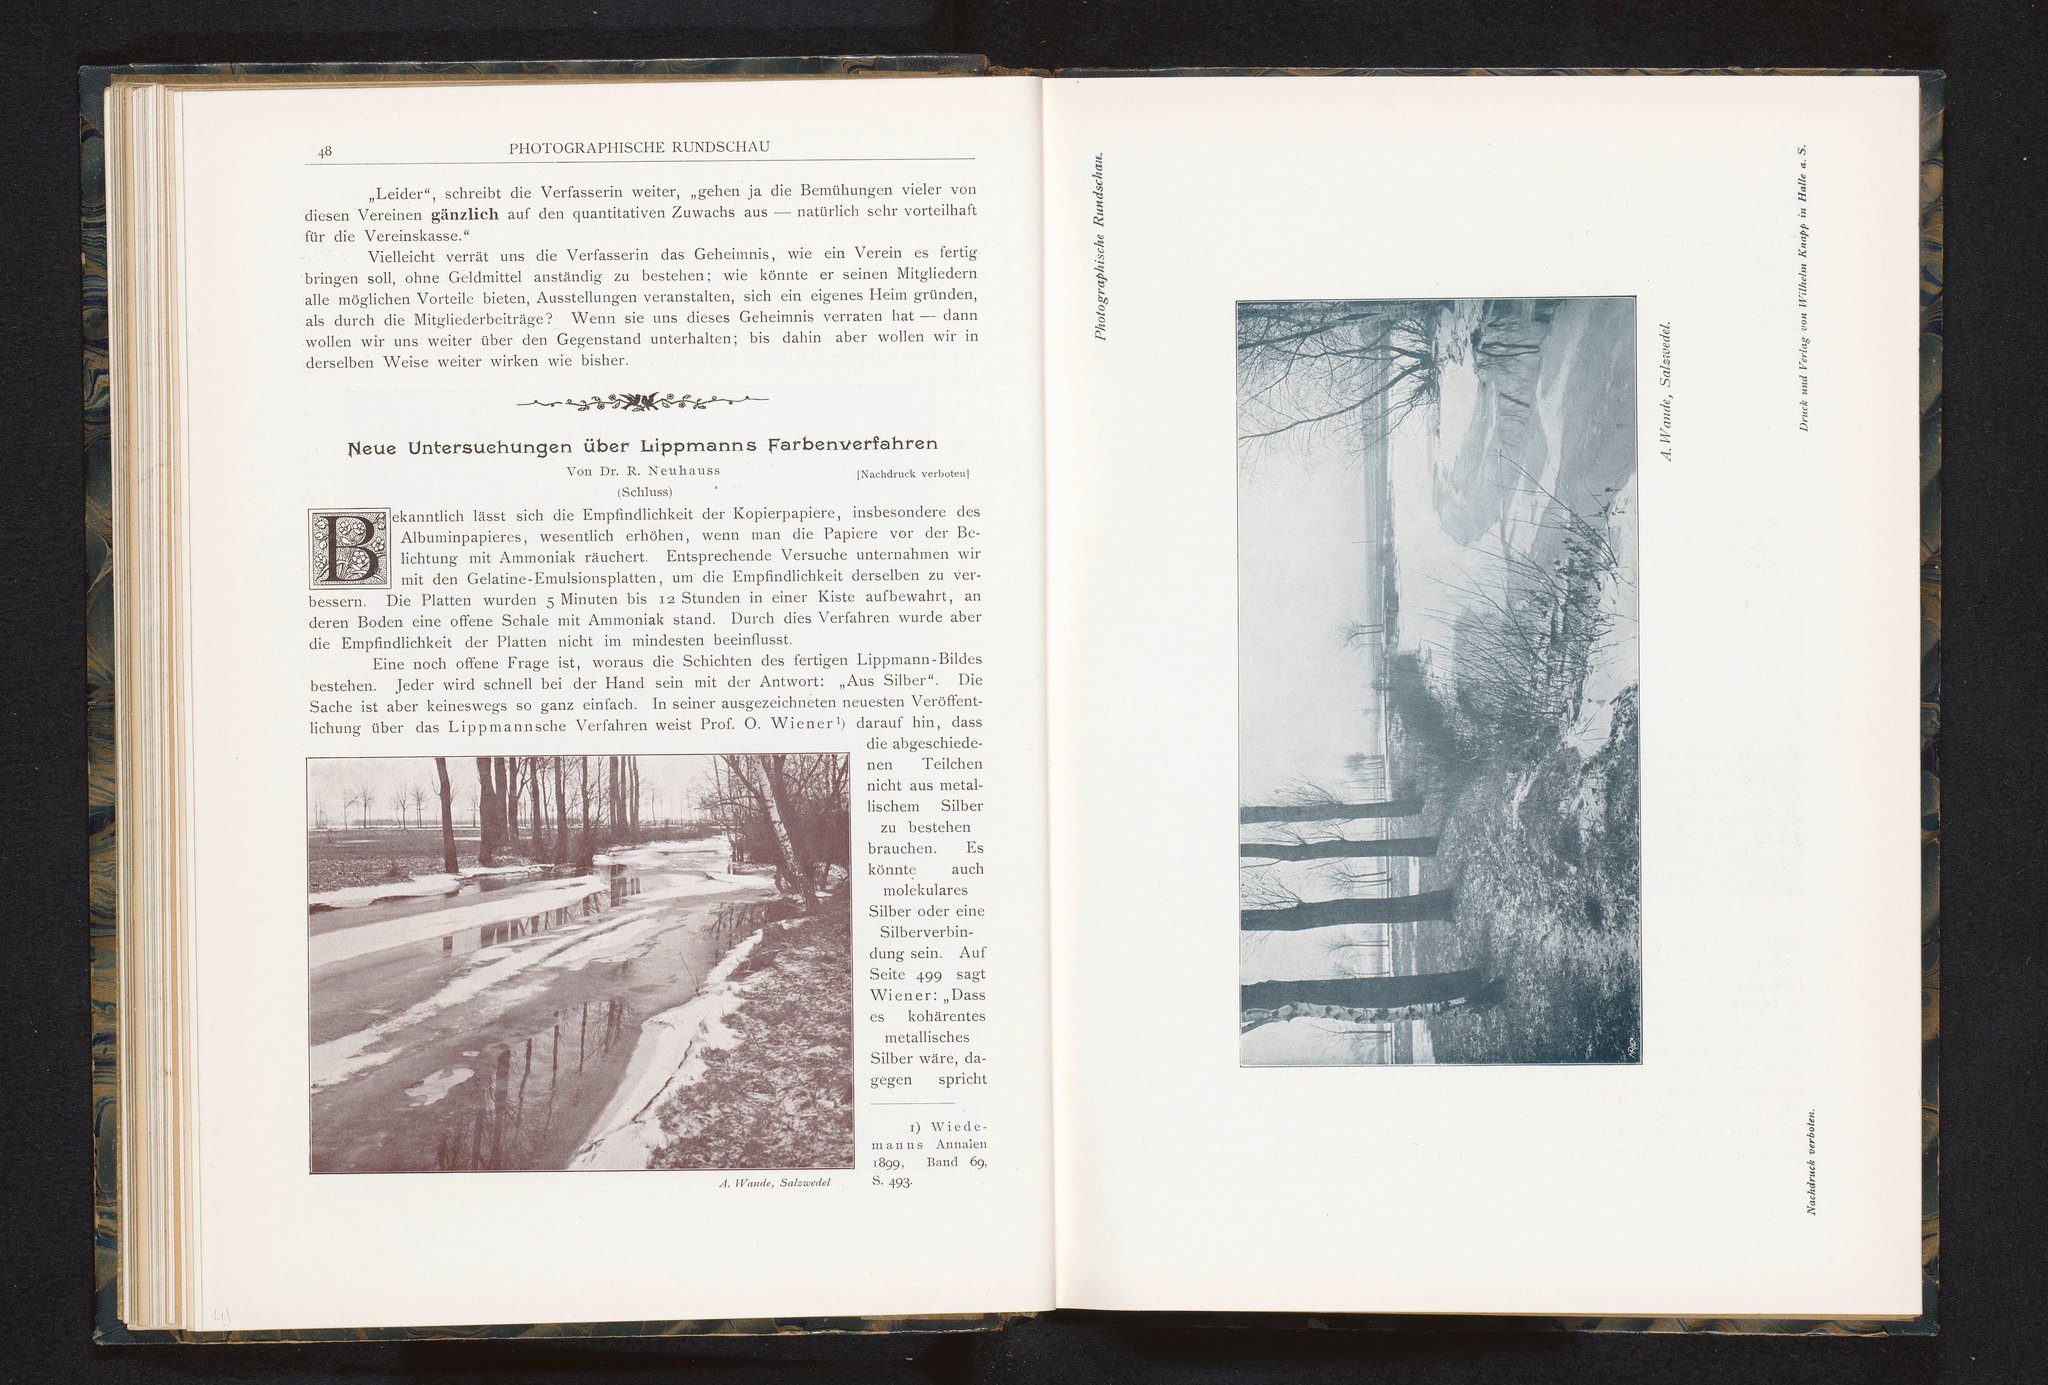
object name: page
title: Gezicht op een winters landschap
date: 1895-1900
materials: paper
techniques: autotype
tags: landscapes, snow